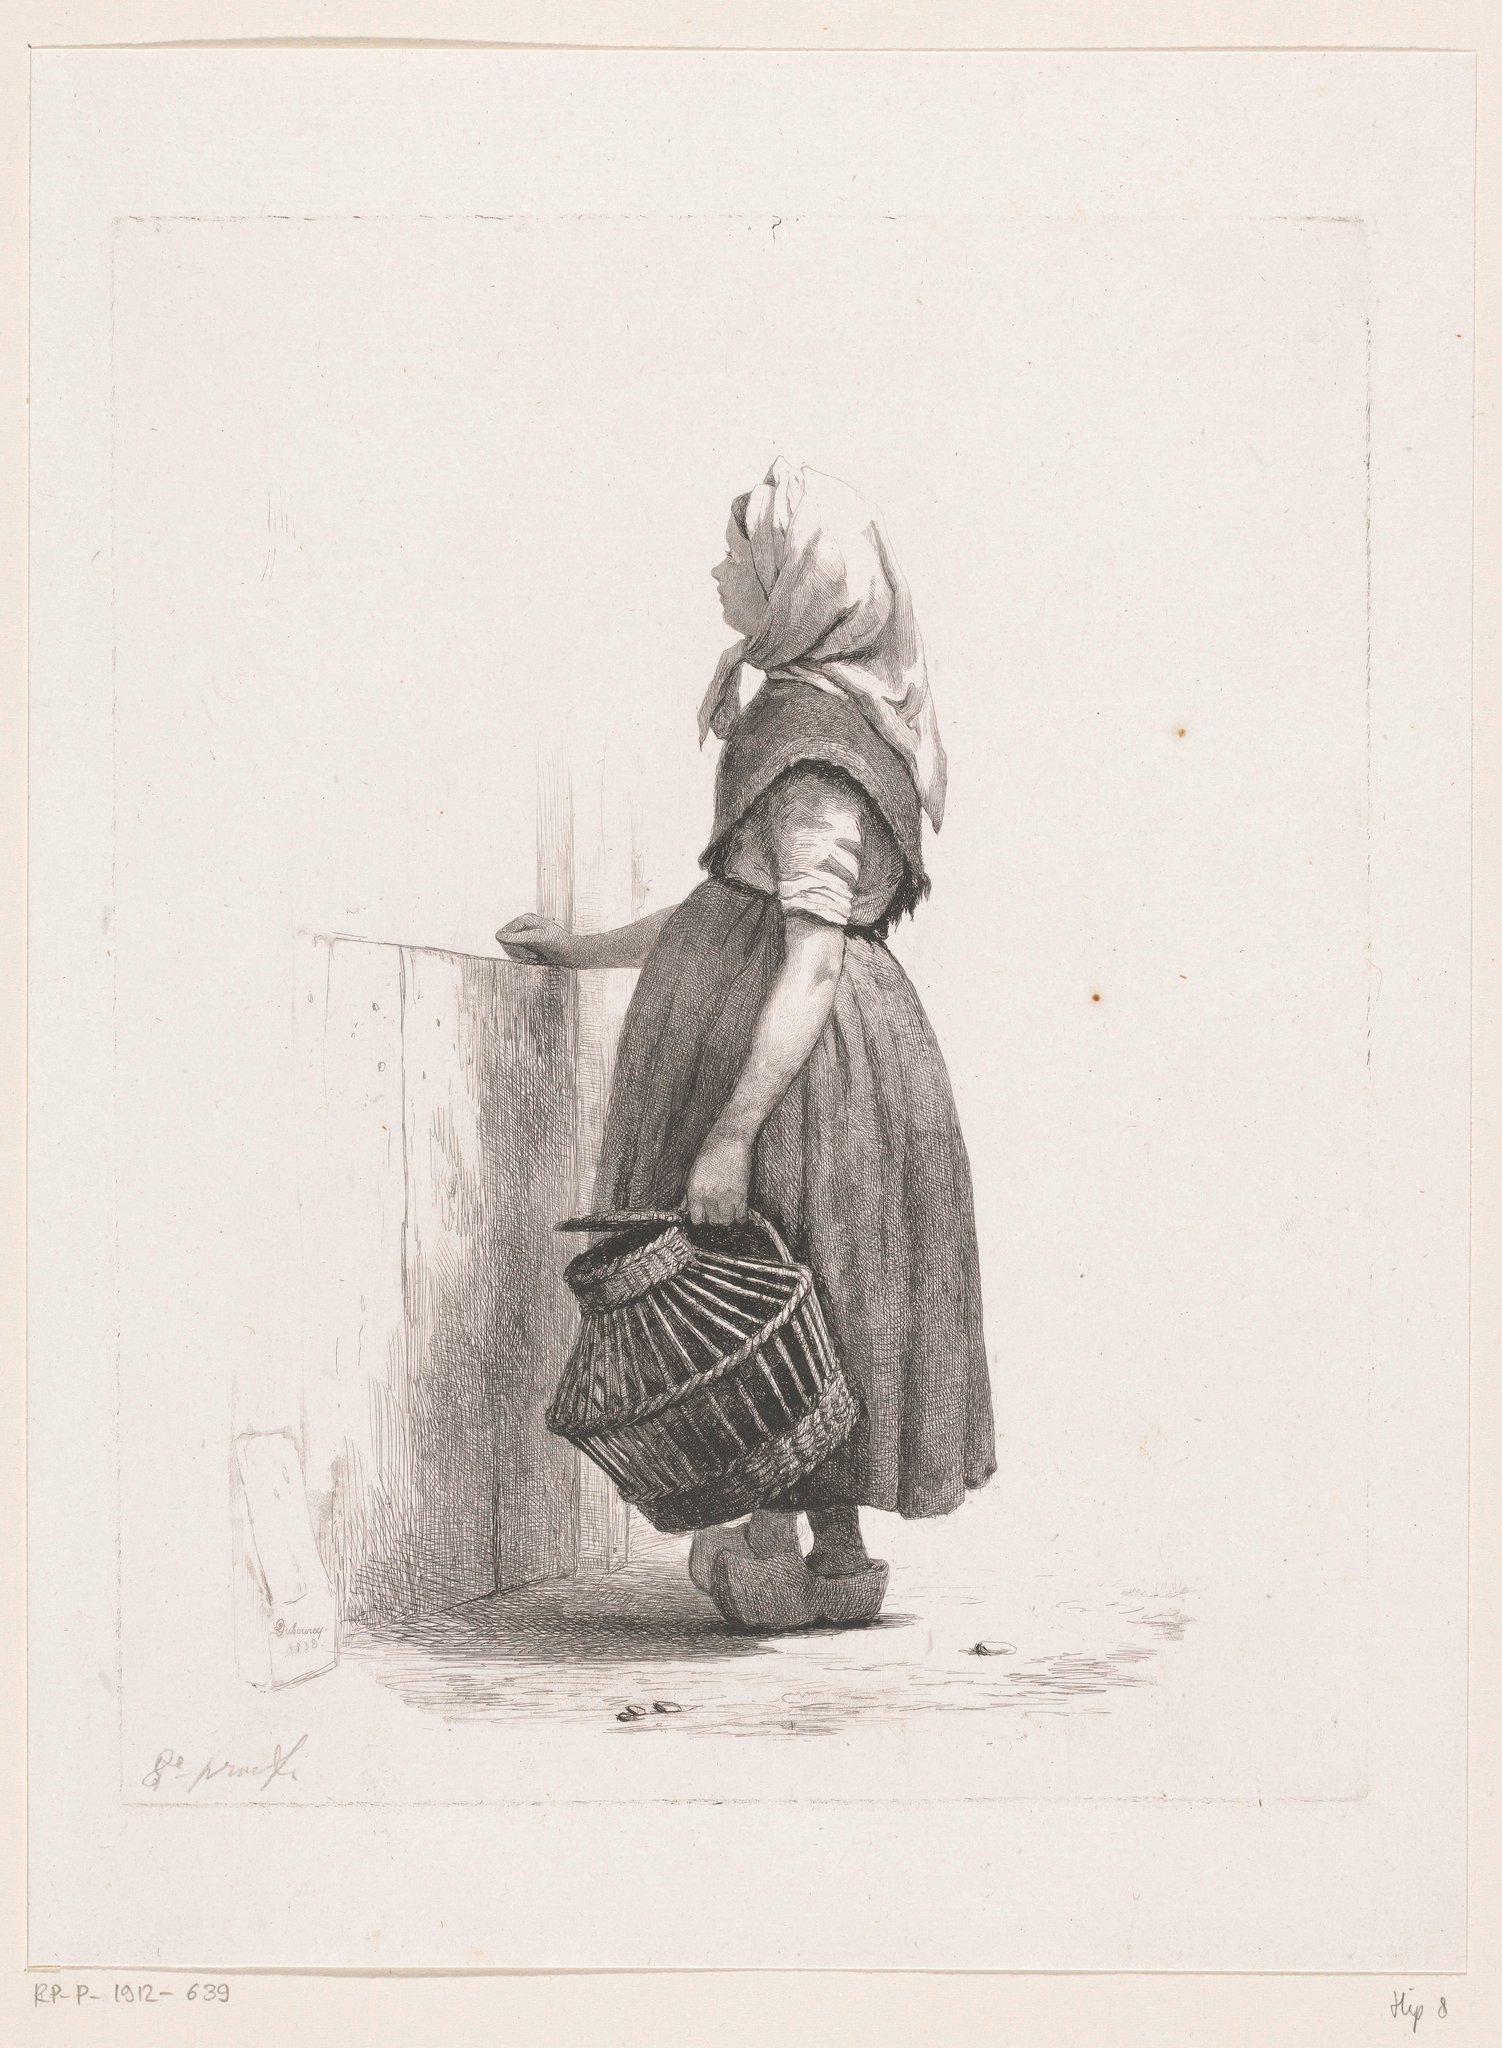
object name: print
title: Vijf etsproeven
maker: pierre louis dubourcq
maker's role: draughtsman, painter, print maker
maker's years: 1815-1873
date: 1838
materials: paper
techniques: drypoint, etching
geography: netherlands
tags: fowl (cock, hen, chicken, etc.) (+ animal cage)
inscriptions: collector's mark: Lugt 2228